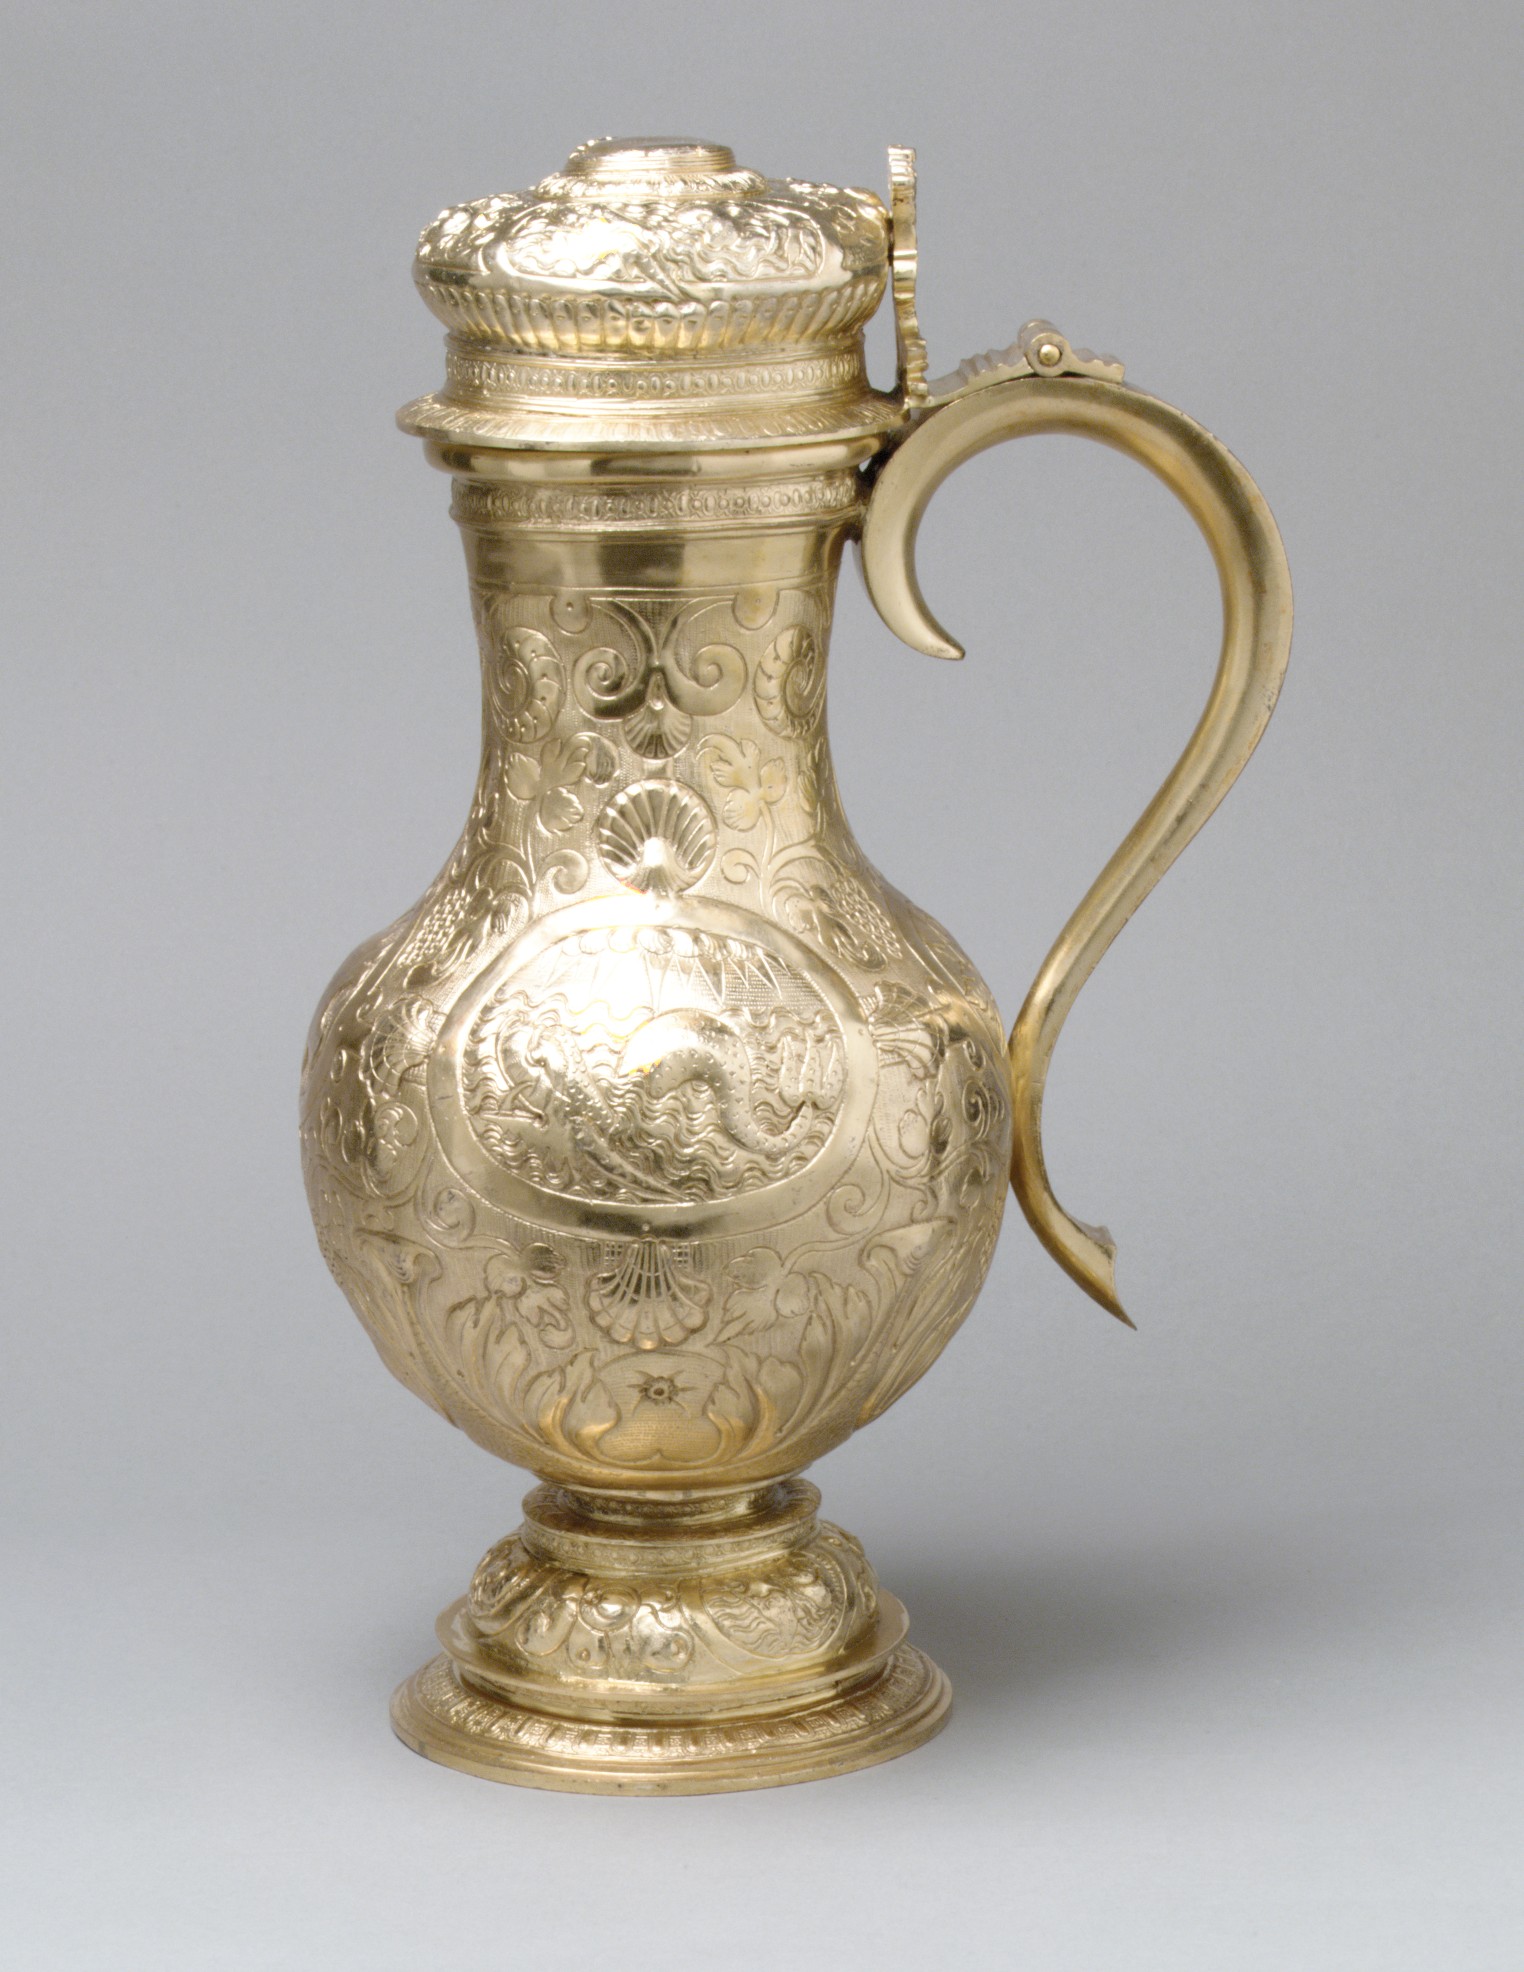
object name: flagon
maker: elkington & co.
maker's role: manufacturer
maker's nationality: british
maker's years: 1829-1963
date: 1801-1900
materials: metal, silver